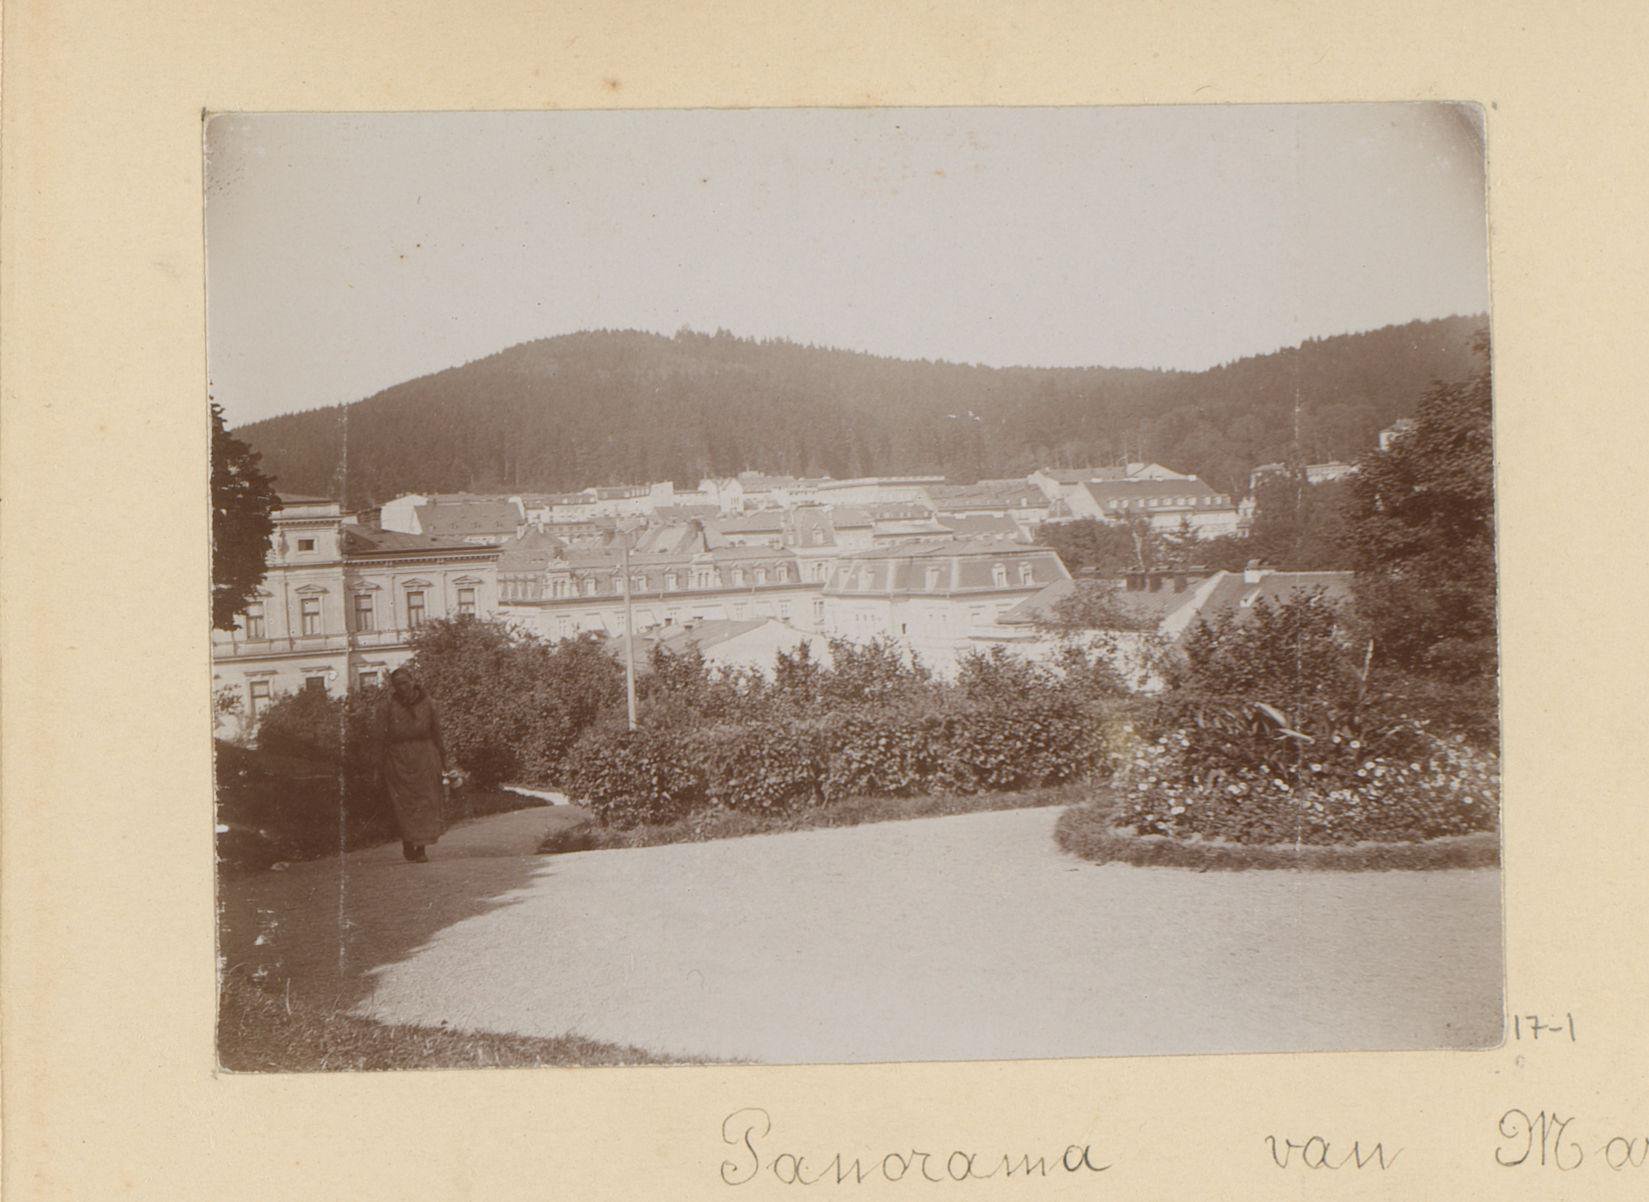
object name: photograph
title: Panorama van Marienbad (1892)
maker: hendrik herman van den berg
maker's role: amateurfotograaf, jurist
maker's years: 1875-1944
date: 1890-1894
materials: paper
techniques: collodion silver print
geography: marienbad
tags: city-view in general; 'veduta', marienbad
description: Foto 1 op albumblad 17 uit album "Amsterdam 1890-1894".